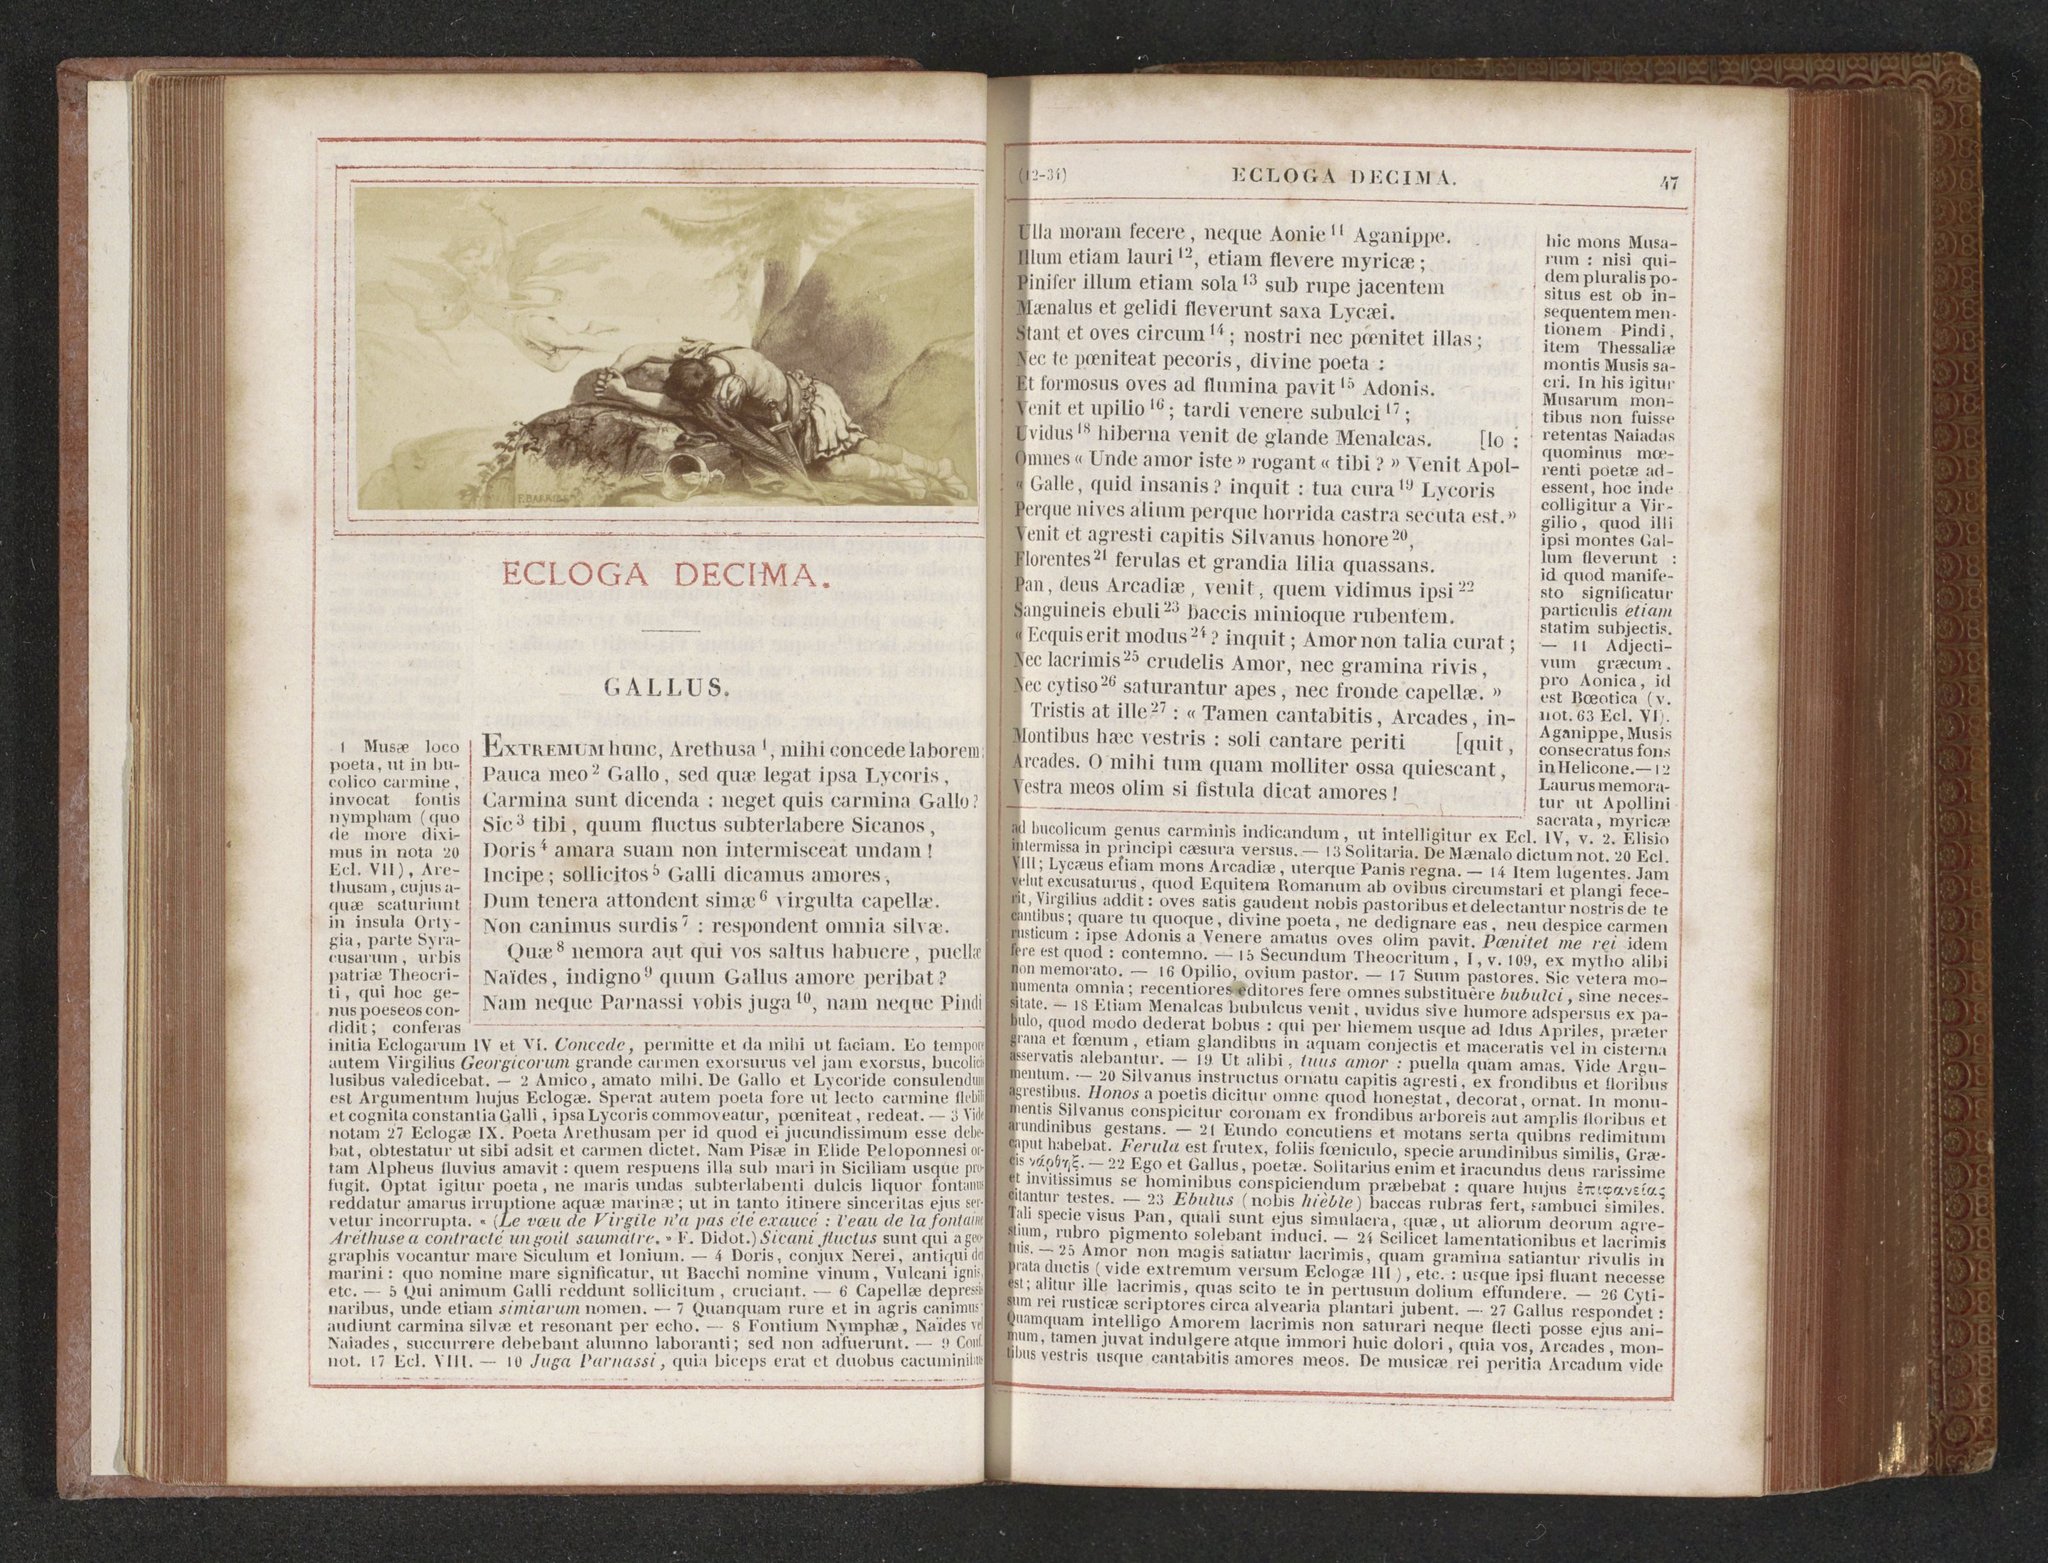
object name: page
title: Fotoreproductie van een schilderij, voorstellende een liggende man en (vermoedelijk) Cupido met een boog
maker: Anonymous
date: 1850-1858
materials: photographic support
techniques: albumen print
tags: lying face downwards, (story of) cupid, amor (eros)